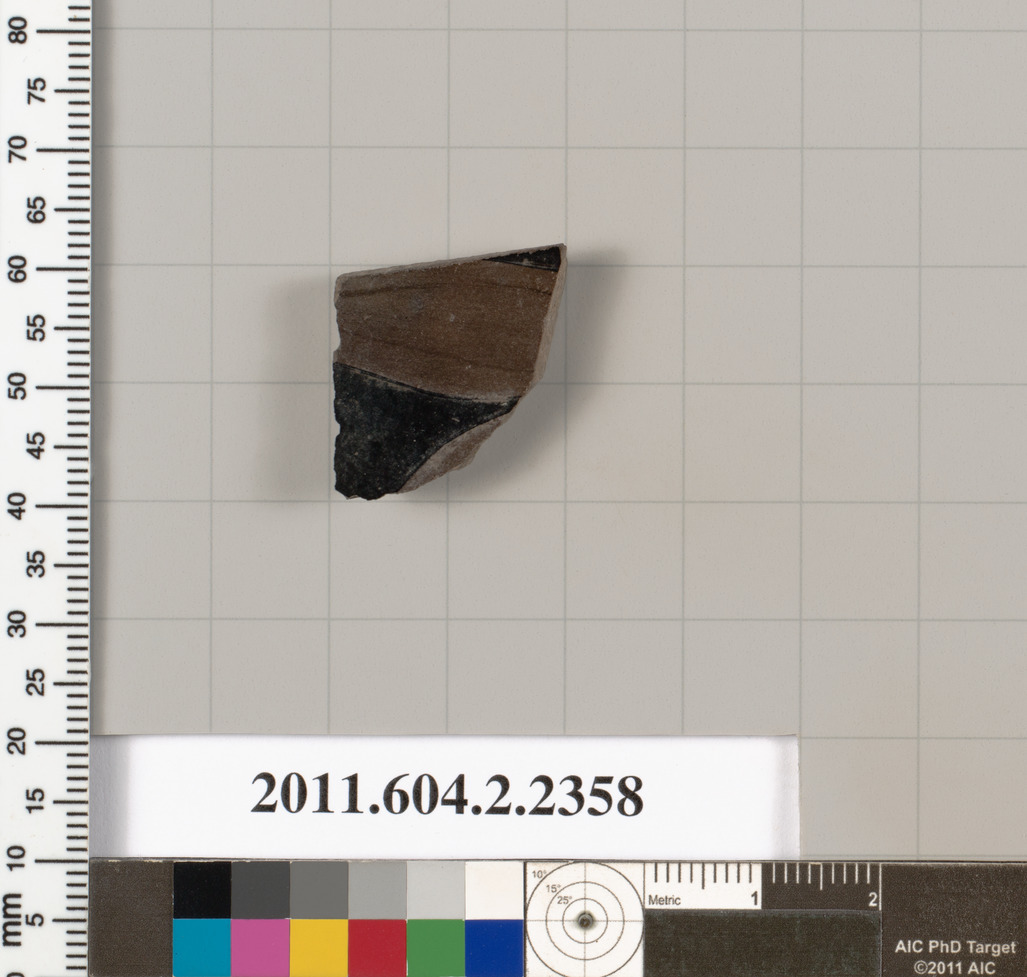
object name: pot fragment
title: Terracotta fragment of a pot; unglazed on the inside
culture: greek, attic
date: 500-480 BCE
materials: terracotta